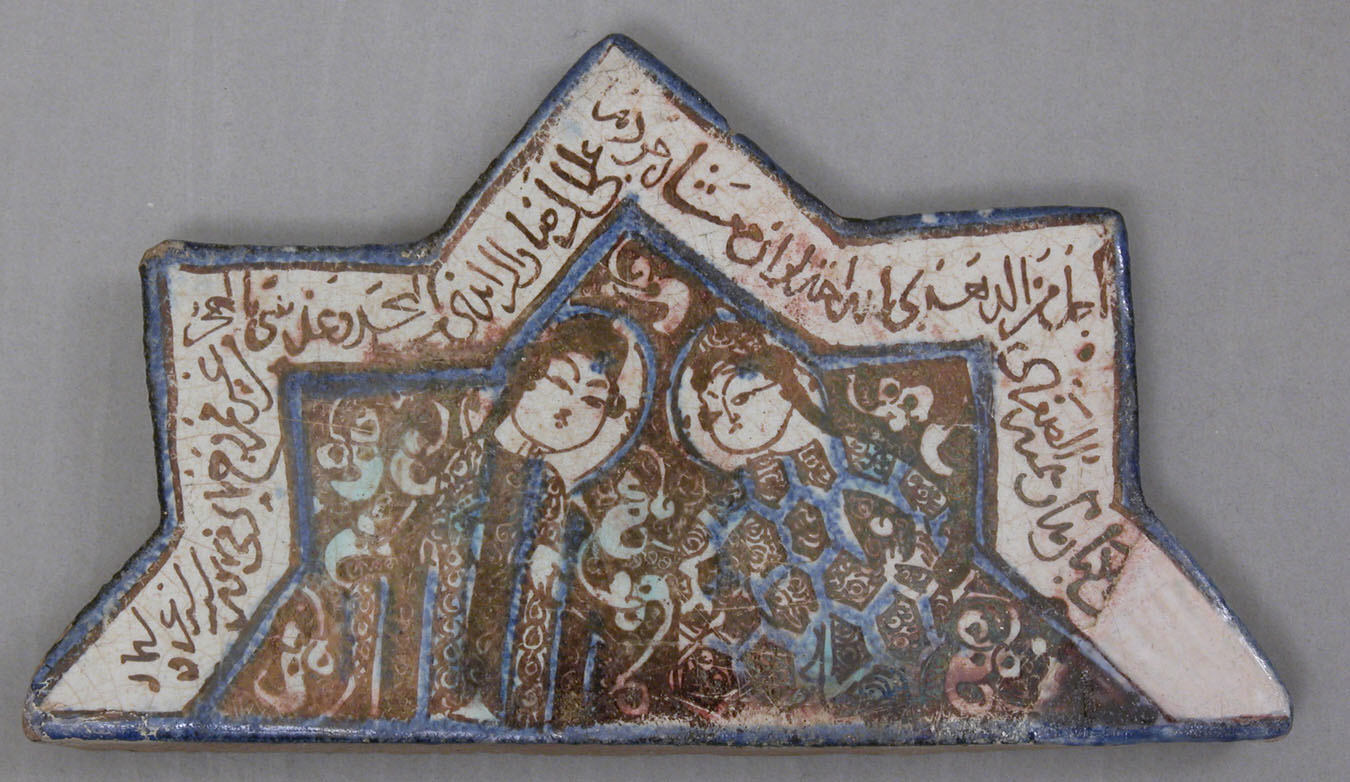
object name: tile fragment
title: Tile, Half Star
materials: glaze, stonepaste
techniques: luster painting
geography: iran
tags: human figures